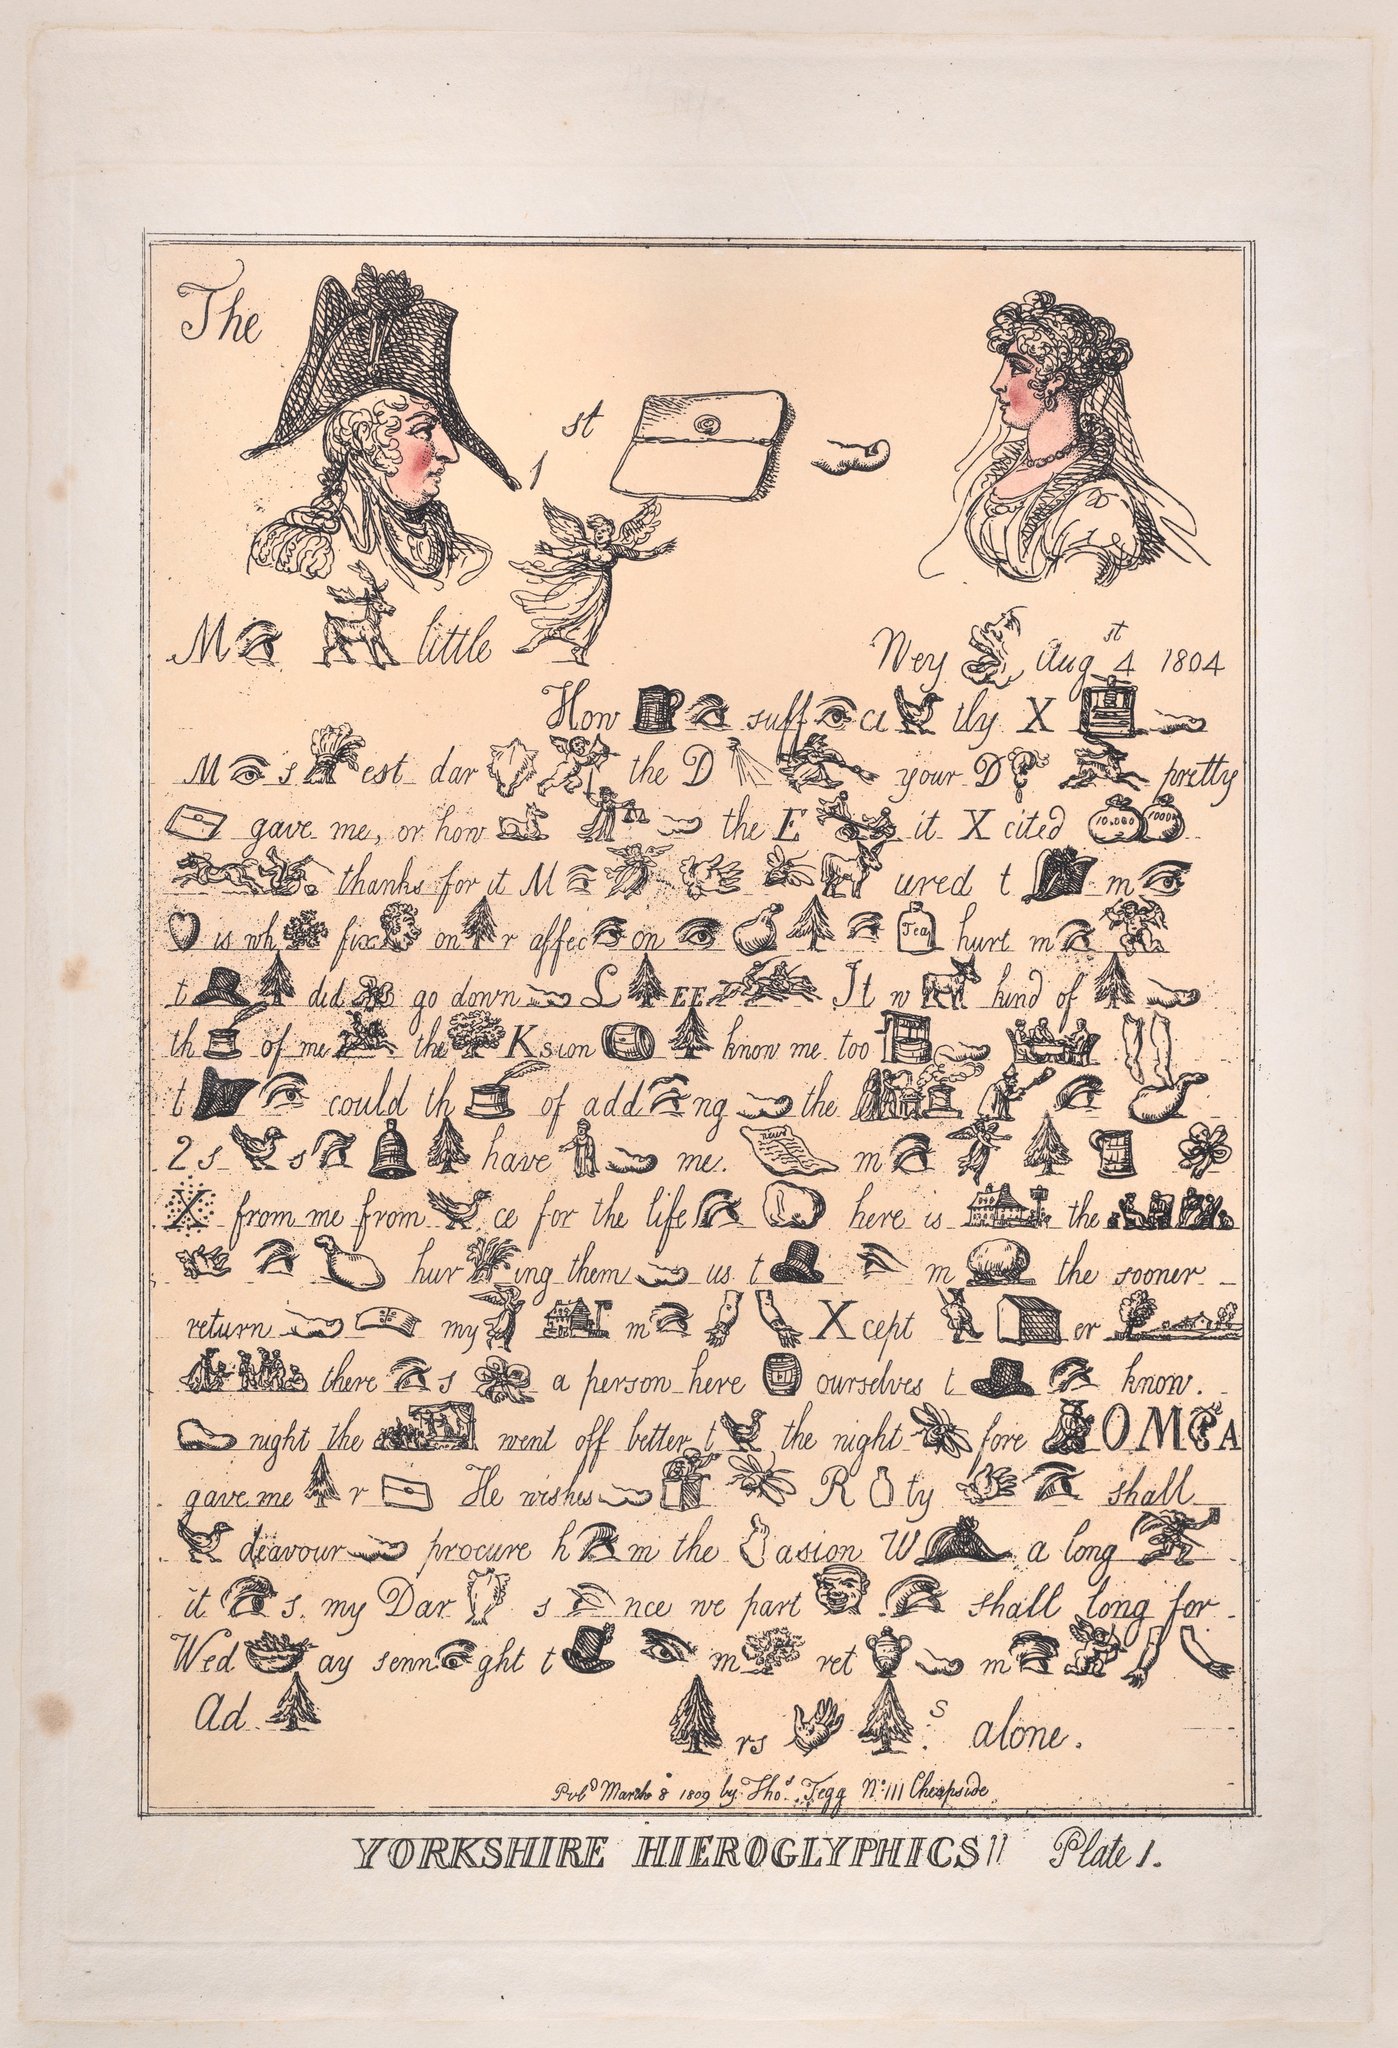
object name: print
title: Yorkshire Hieroglyphics, Plate 1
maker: thomas rowlandson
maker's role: artist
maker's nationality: british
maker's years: 1757-1827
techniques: etching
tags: satire,hieroglyphs,politics